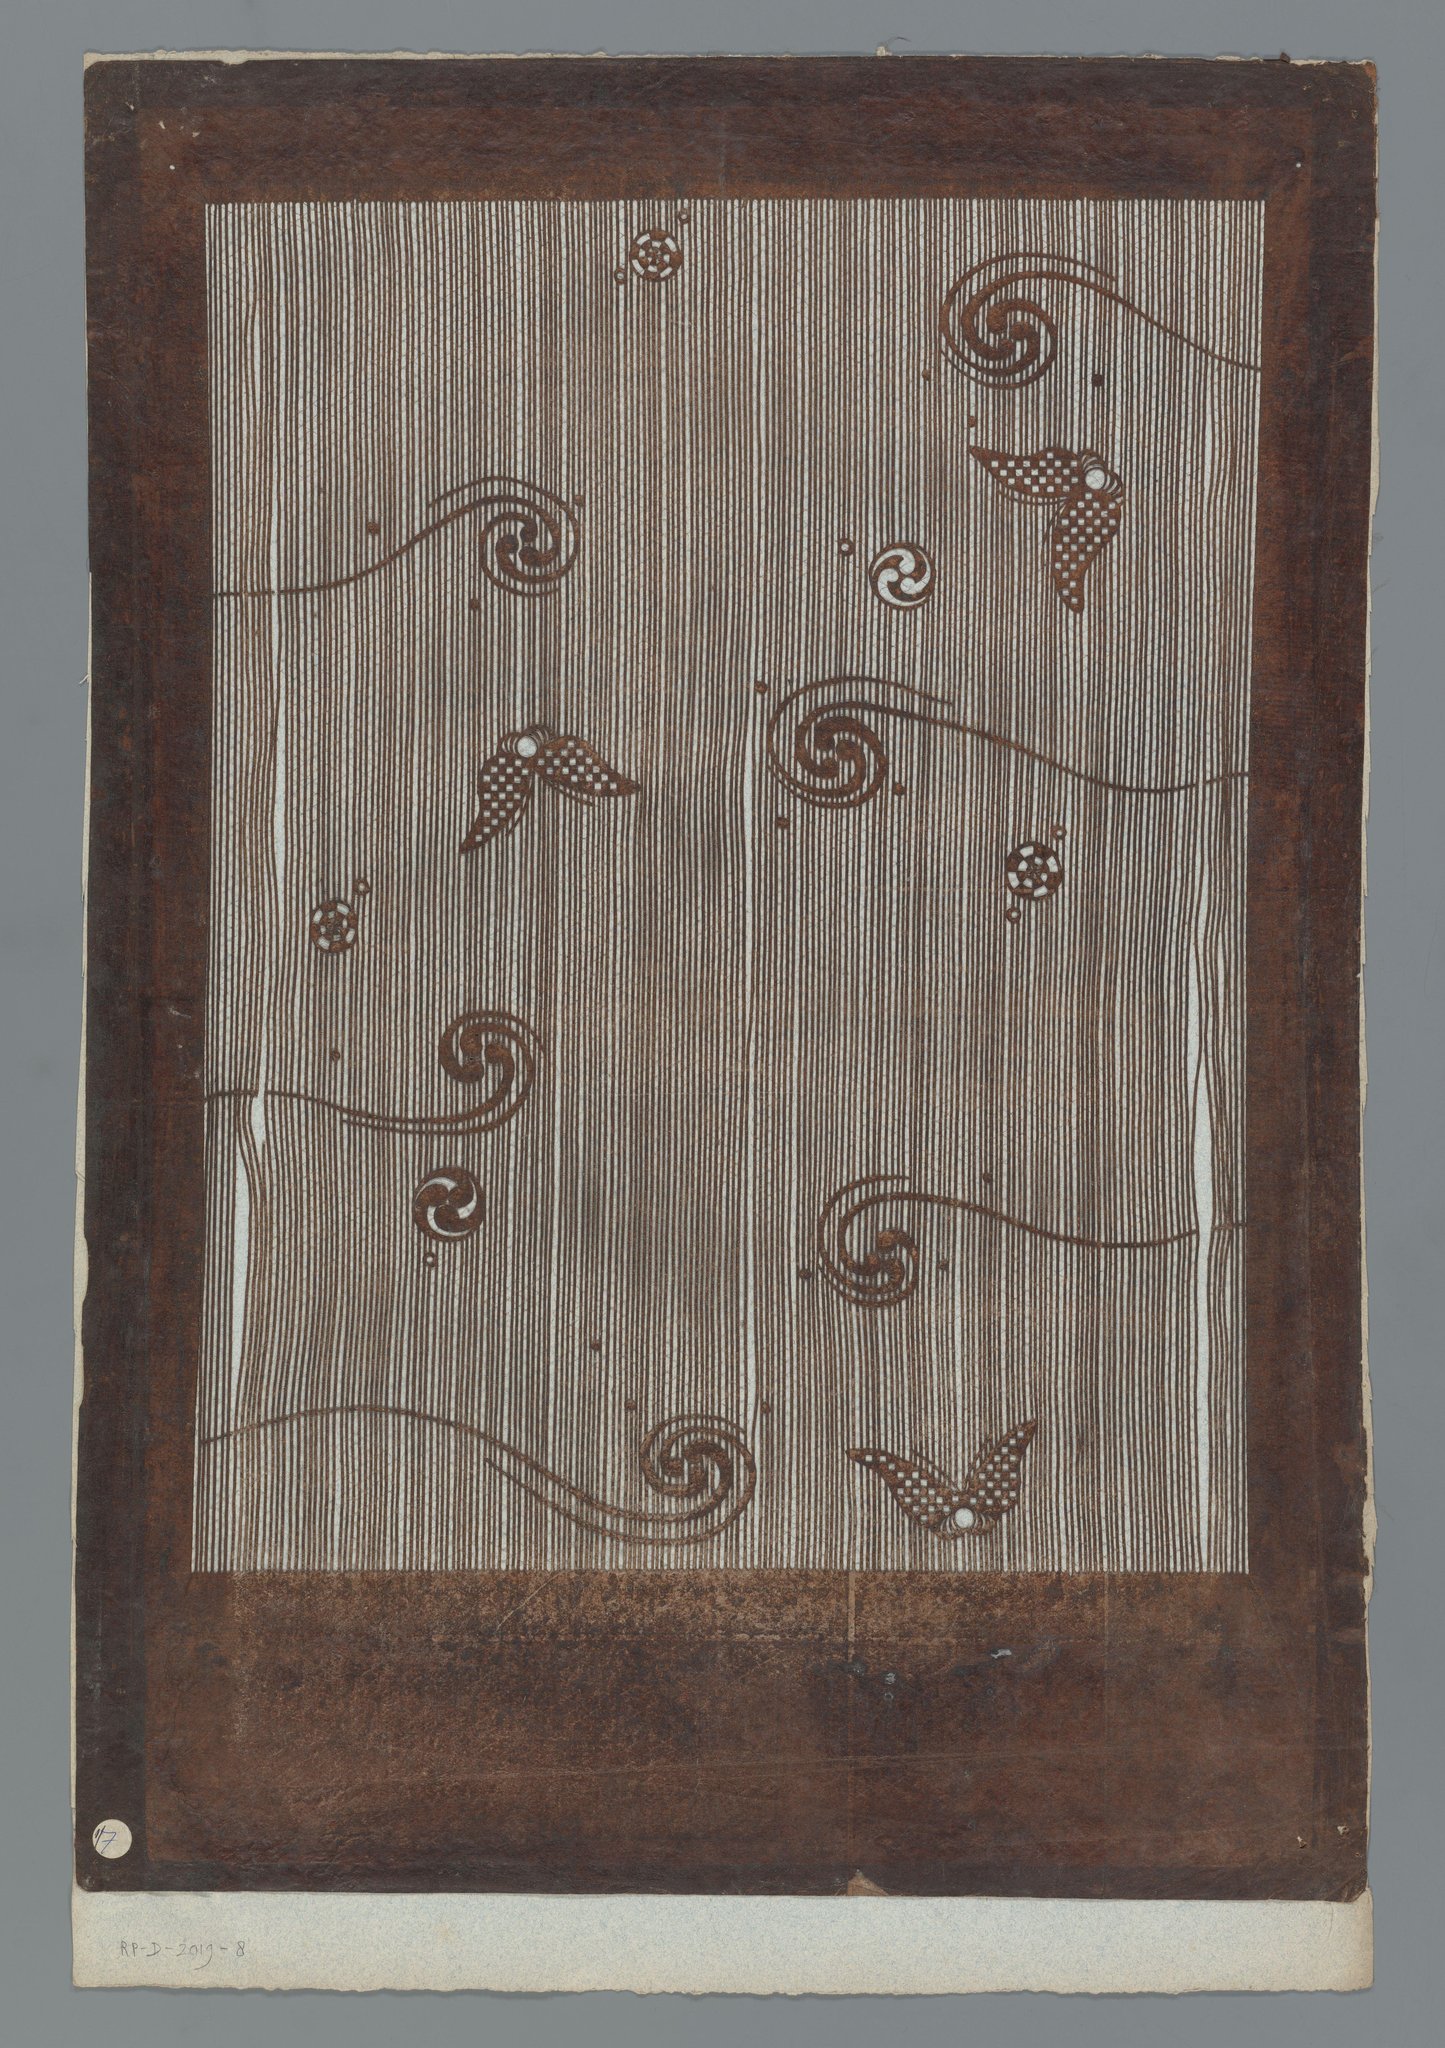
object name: katagami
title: Sjabloon met vlinders en spiralen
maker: Anonymous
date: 1800-1909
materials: paper, silk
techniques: cutting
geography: japan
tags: ornament derived from animal forms, ornament ~ rotating forms, insects: butterfly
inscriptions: stamp: ‘472/23’, label: ‘1/7’, label: ‘5403 / 15.-’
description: Japanse sjabloon (katagami) met een patroon van vlinders, spiralen en losse ronde vormen, tegen een uniform achtergrond van verticale lijnen.